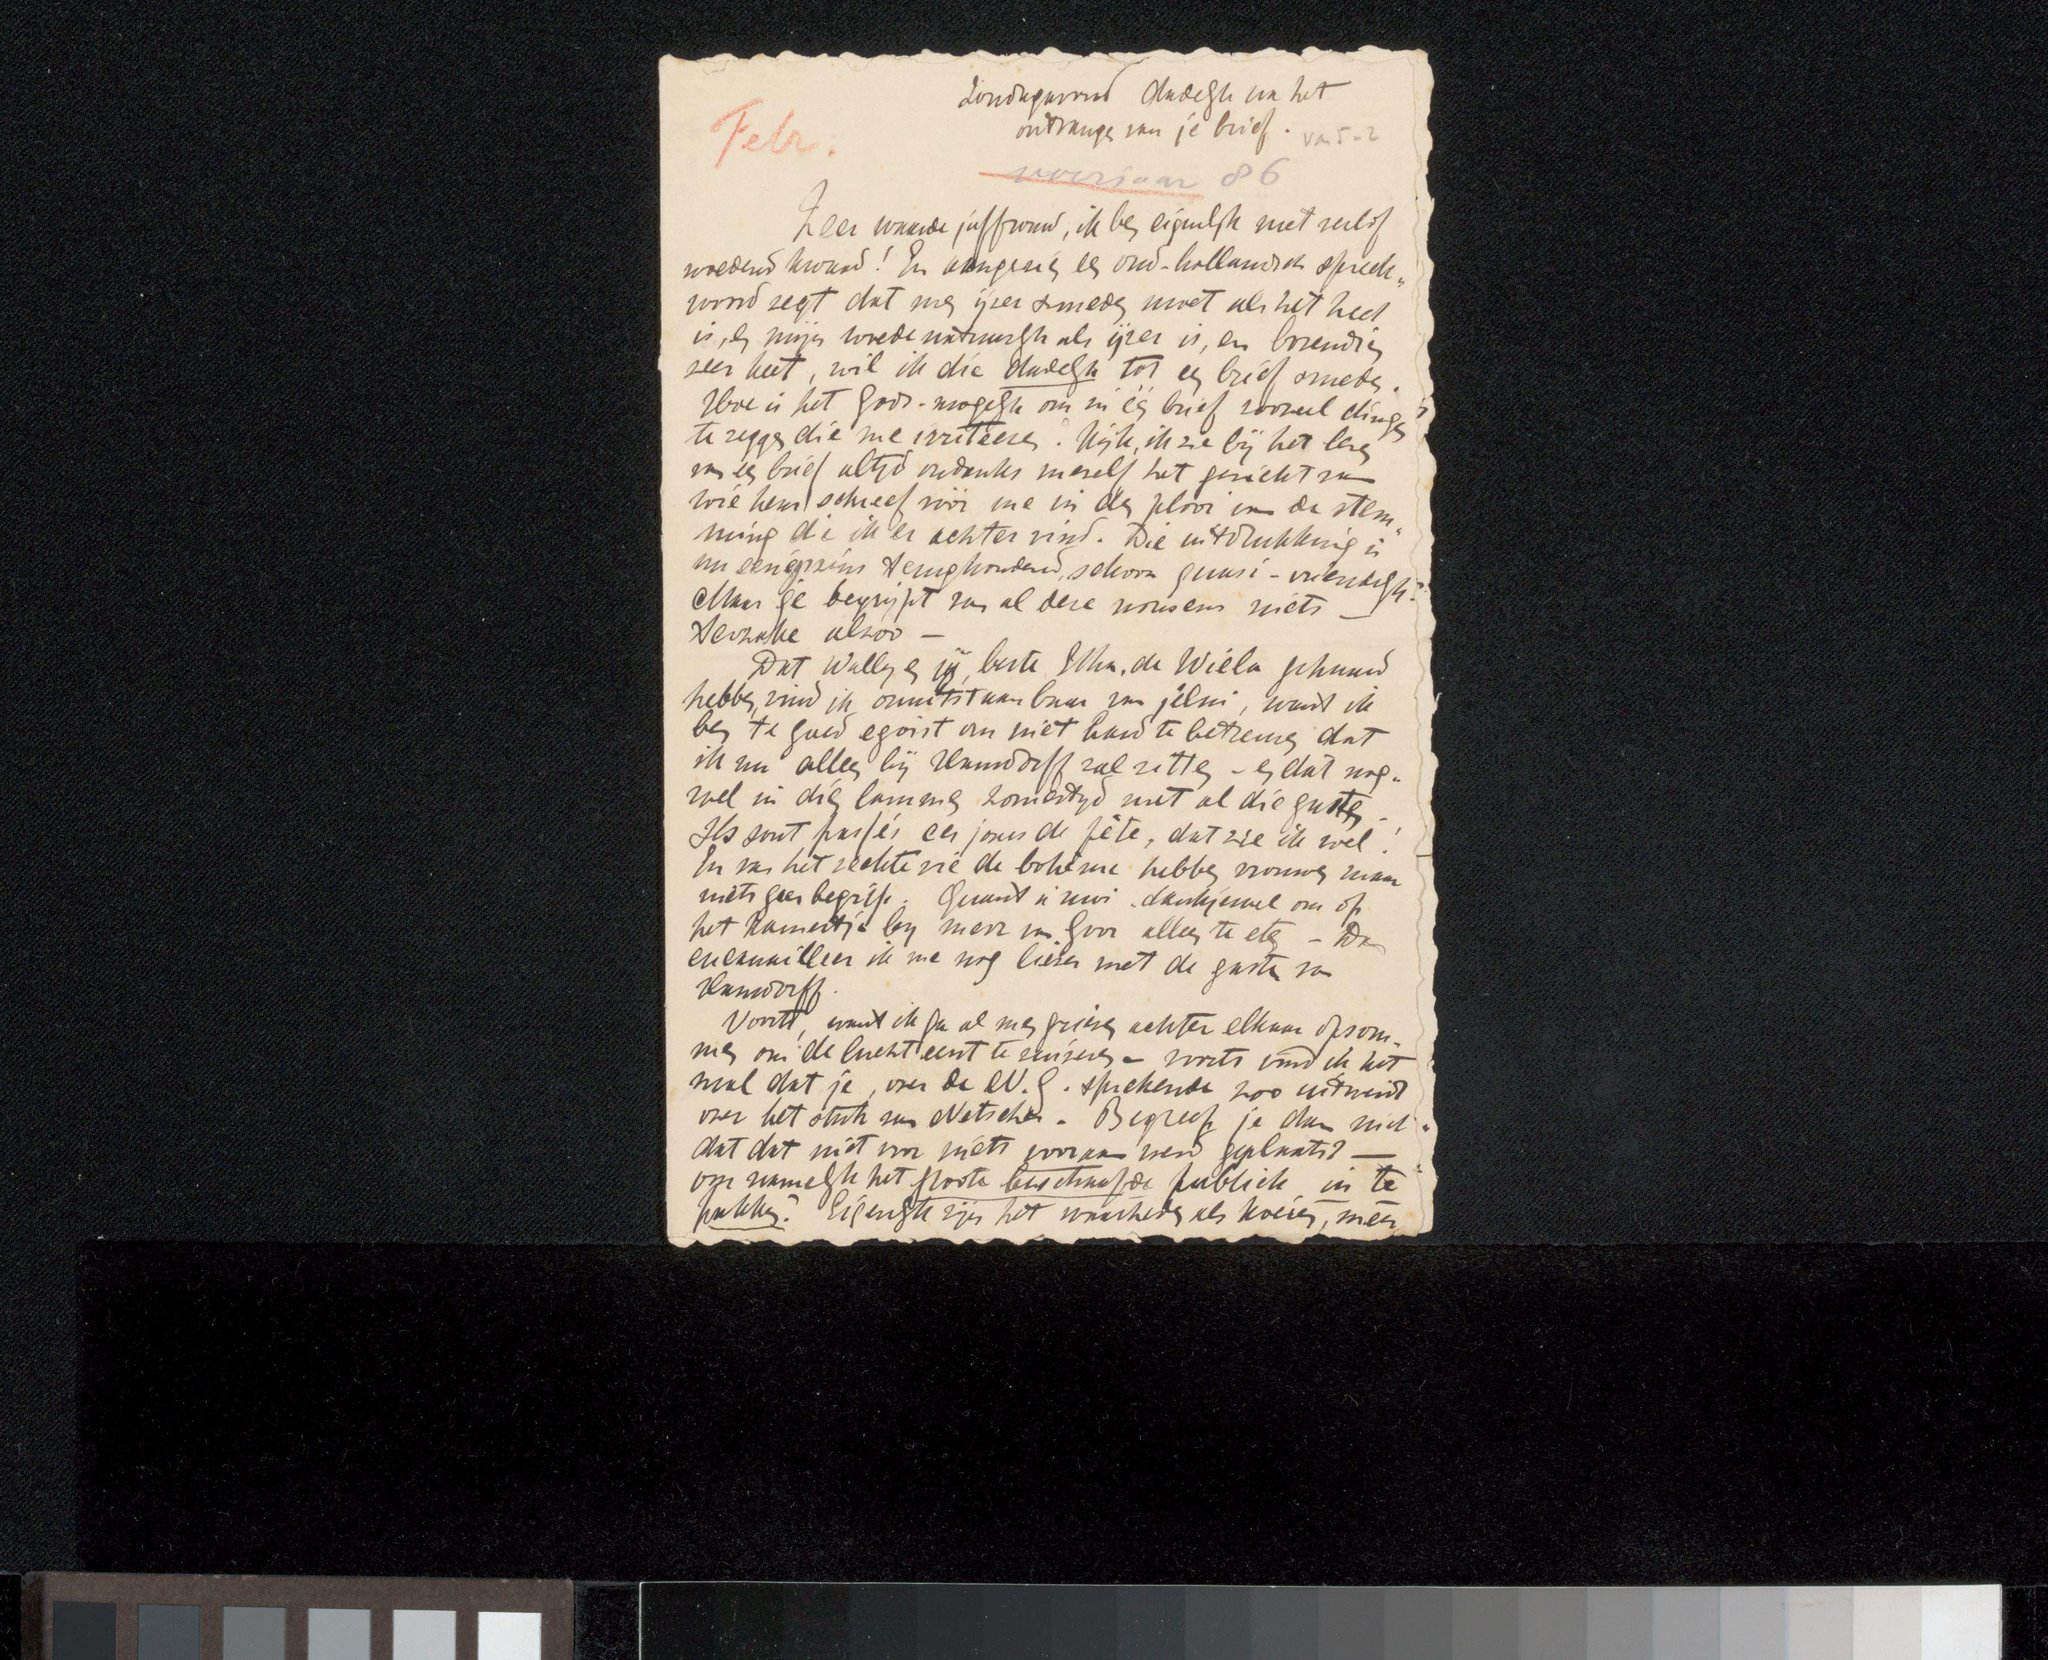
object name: letter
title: Brief aan Etha Fles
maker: jan veth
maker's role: designer, draughtsman, painter, print maker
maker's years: 1864-1925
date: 1874-1925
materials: ink, paper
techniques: pen, writing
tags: rotterdam, amsterdam, painter, draughtsman, george hendrik breitner, arnhem, anton mauve, willem witsen, wally moes, utrecht, print maker, etha fles, haarlem, frederik van eeden, frans netscher, literature ~ arts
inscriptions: collector's mark: ‘RPK’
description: Brief gedateerd voorjaar 86 in latere hand.